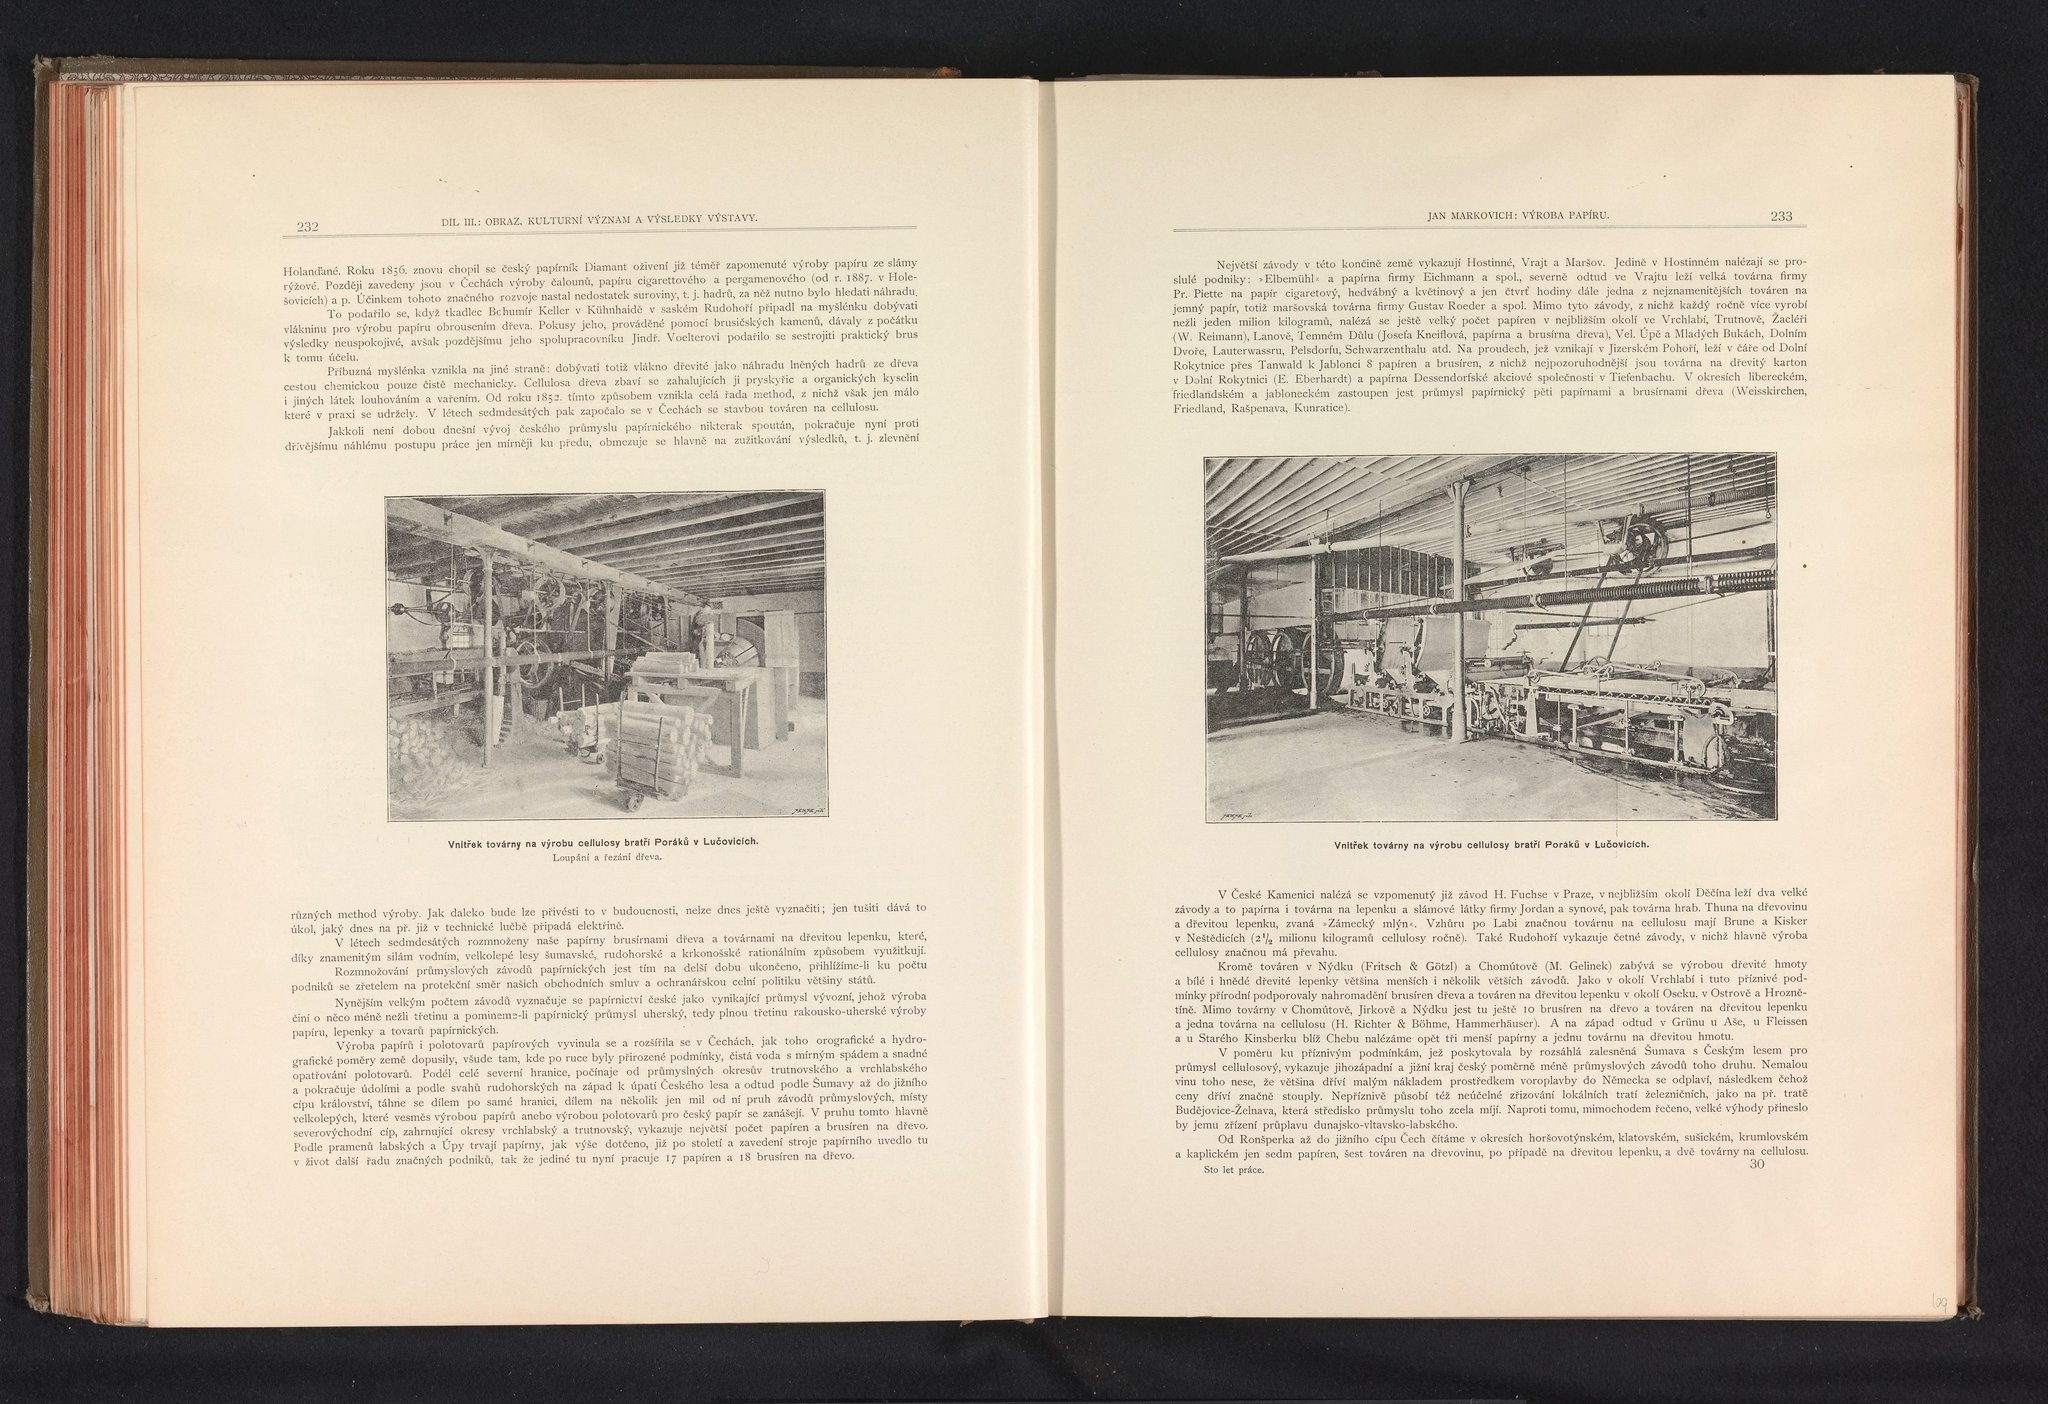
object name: photomechanical print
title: Vnitrek továrny na výrobu cellulosy bratri Poráku v Lucovicich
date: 1891-1895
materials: paper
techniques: autotype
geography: prague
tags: factory-interior, machine shop